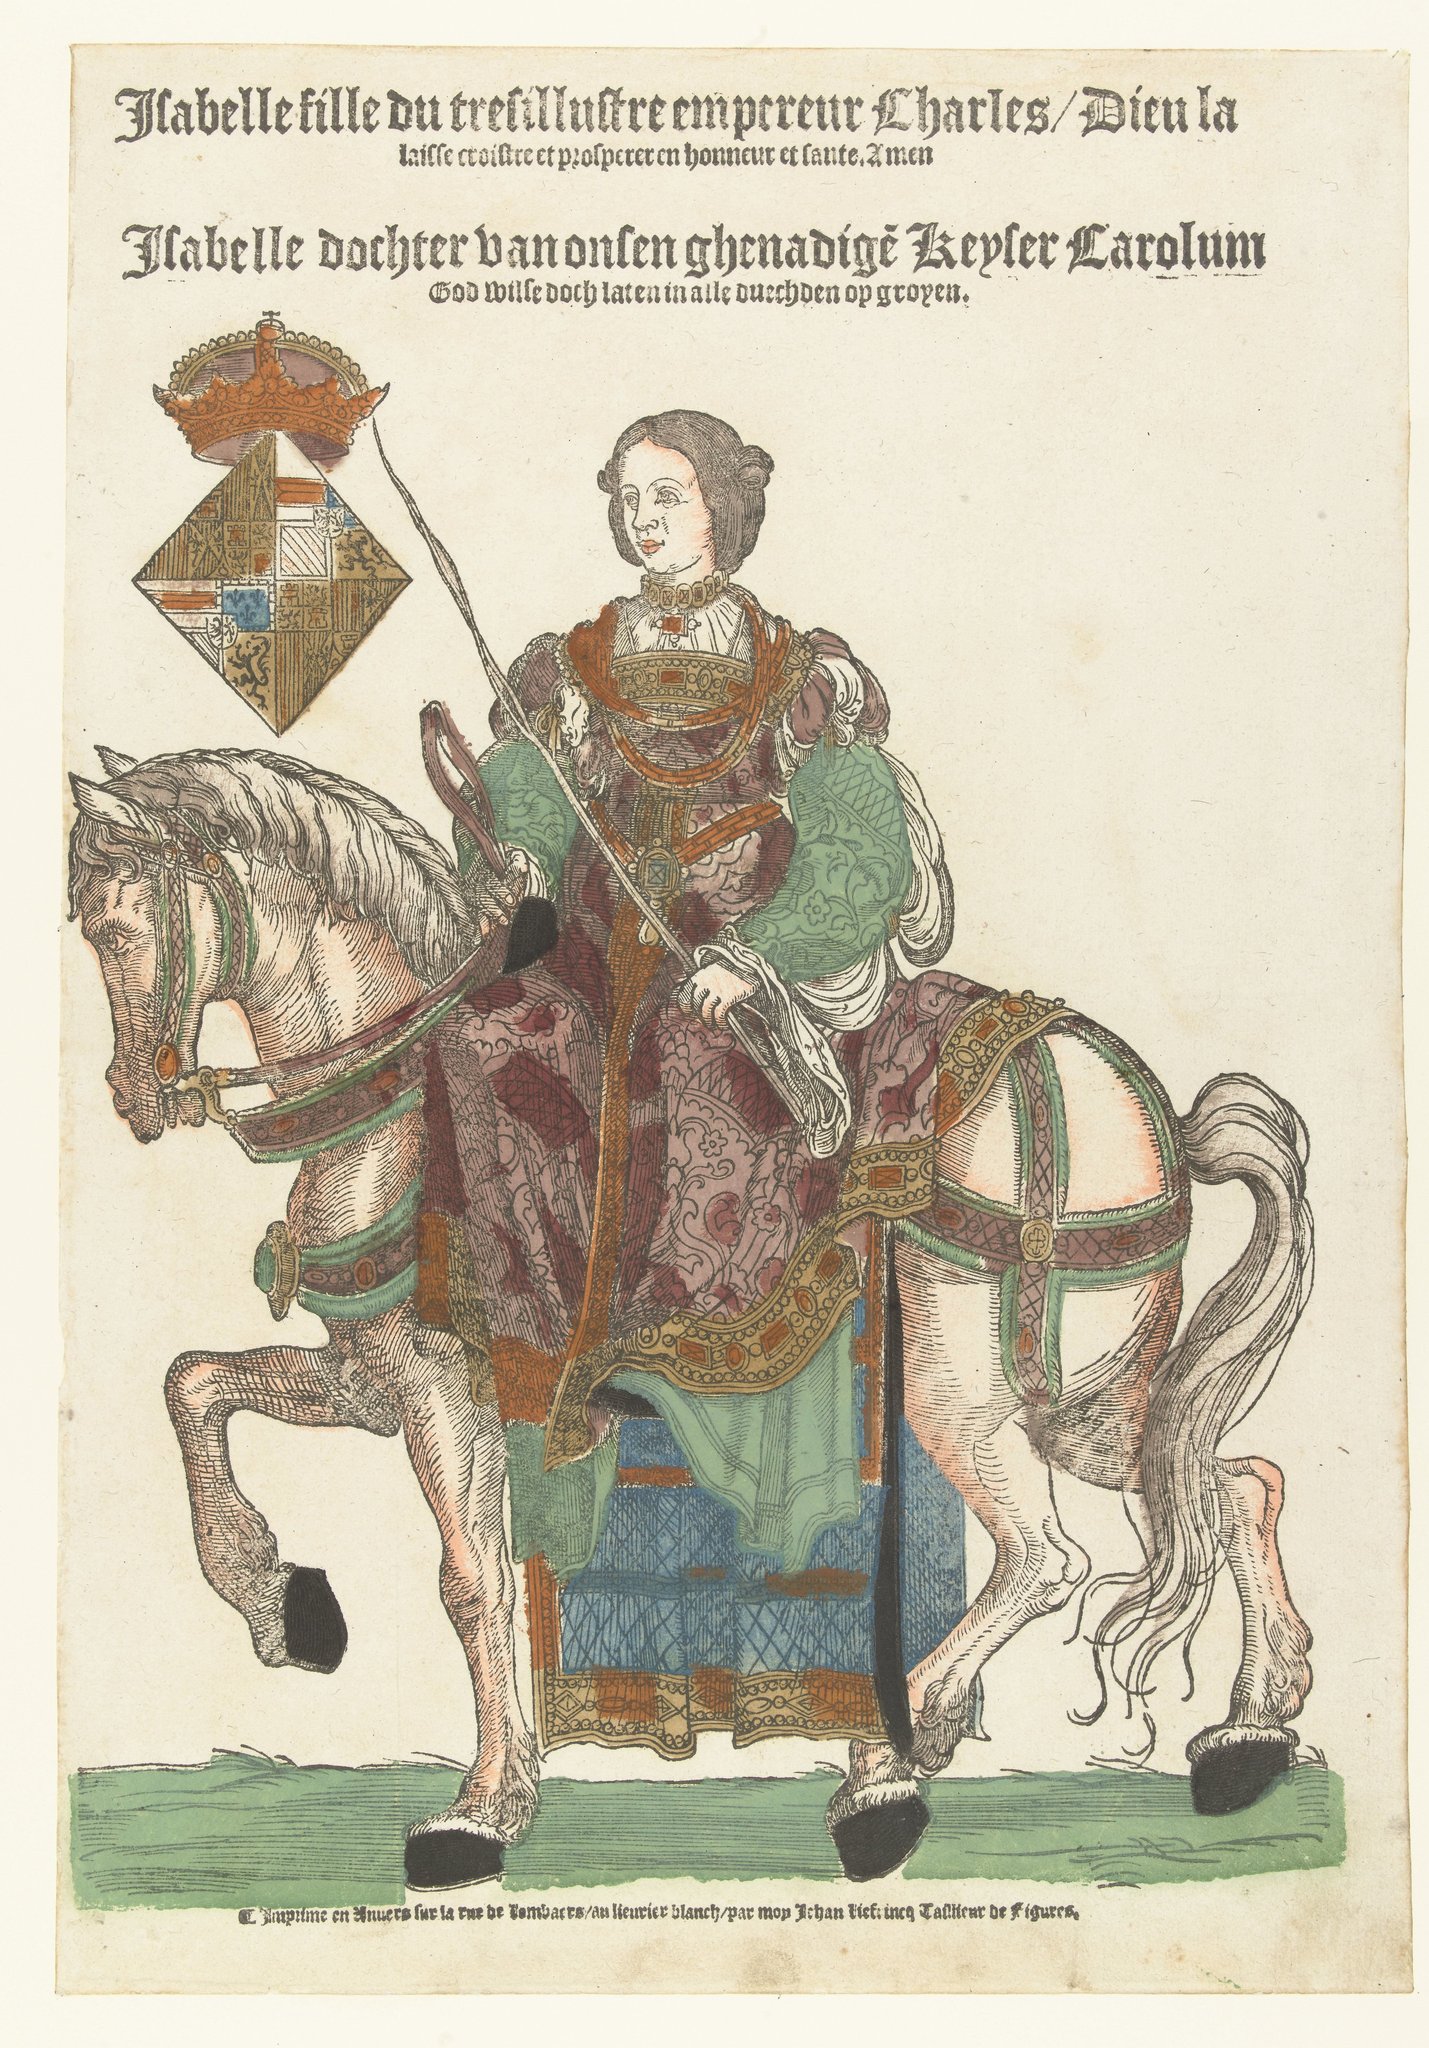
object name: print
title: Portret van prinses Johanna van Habsburg te paard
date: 1539-1552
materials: paper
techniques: hand coloring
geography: antwerp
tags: riding a horse, ass, or mule; rider, horseman, historical persons - bb - woman, myth of the returning emperor - bb - female ruler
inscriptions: inscription: ‘Isabelle fille du tresillustre empereur Charles...op groyen.’, address: ‘Imprime en Anvers sur la rue de Lombaers/ au lieurier blanch/par moy Jehan Liefrincq Taillieur de Figueres’, number: ‘29’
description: amazonekostuum 1525-1535